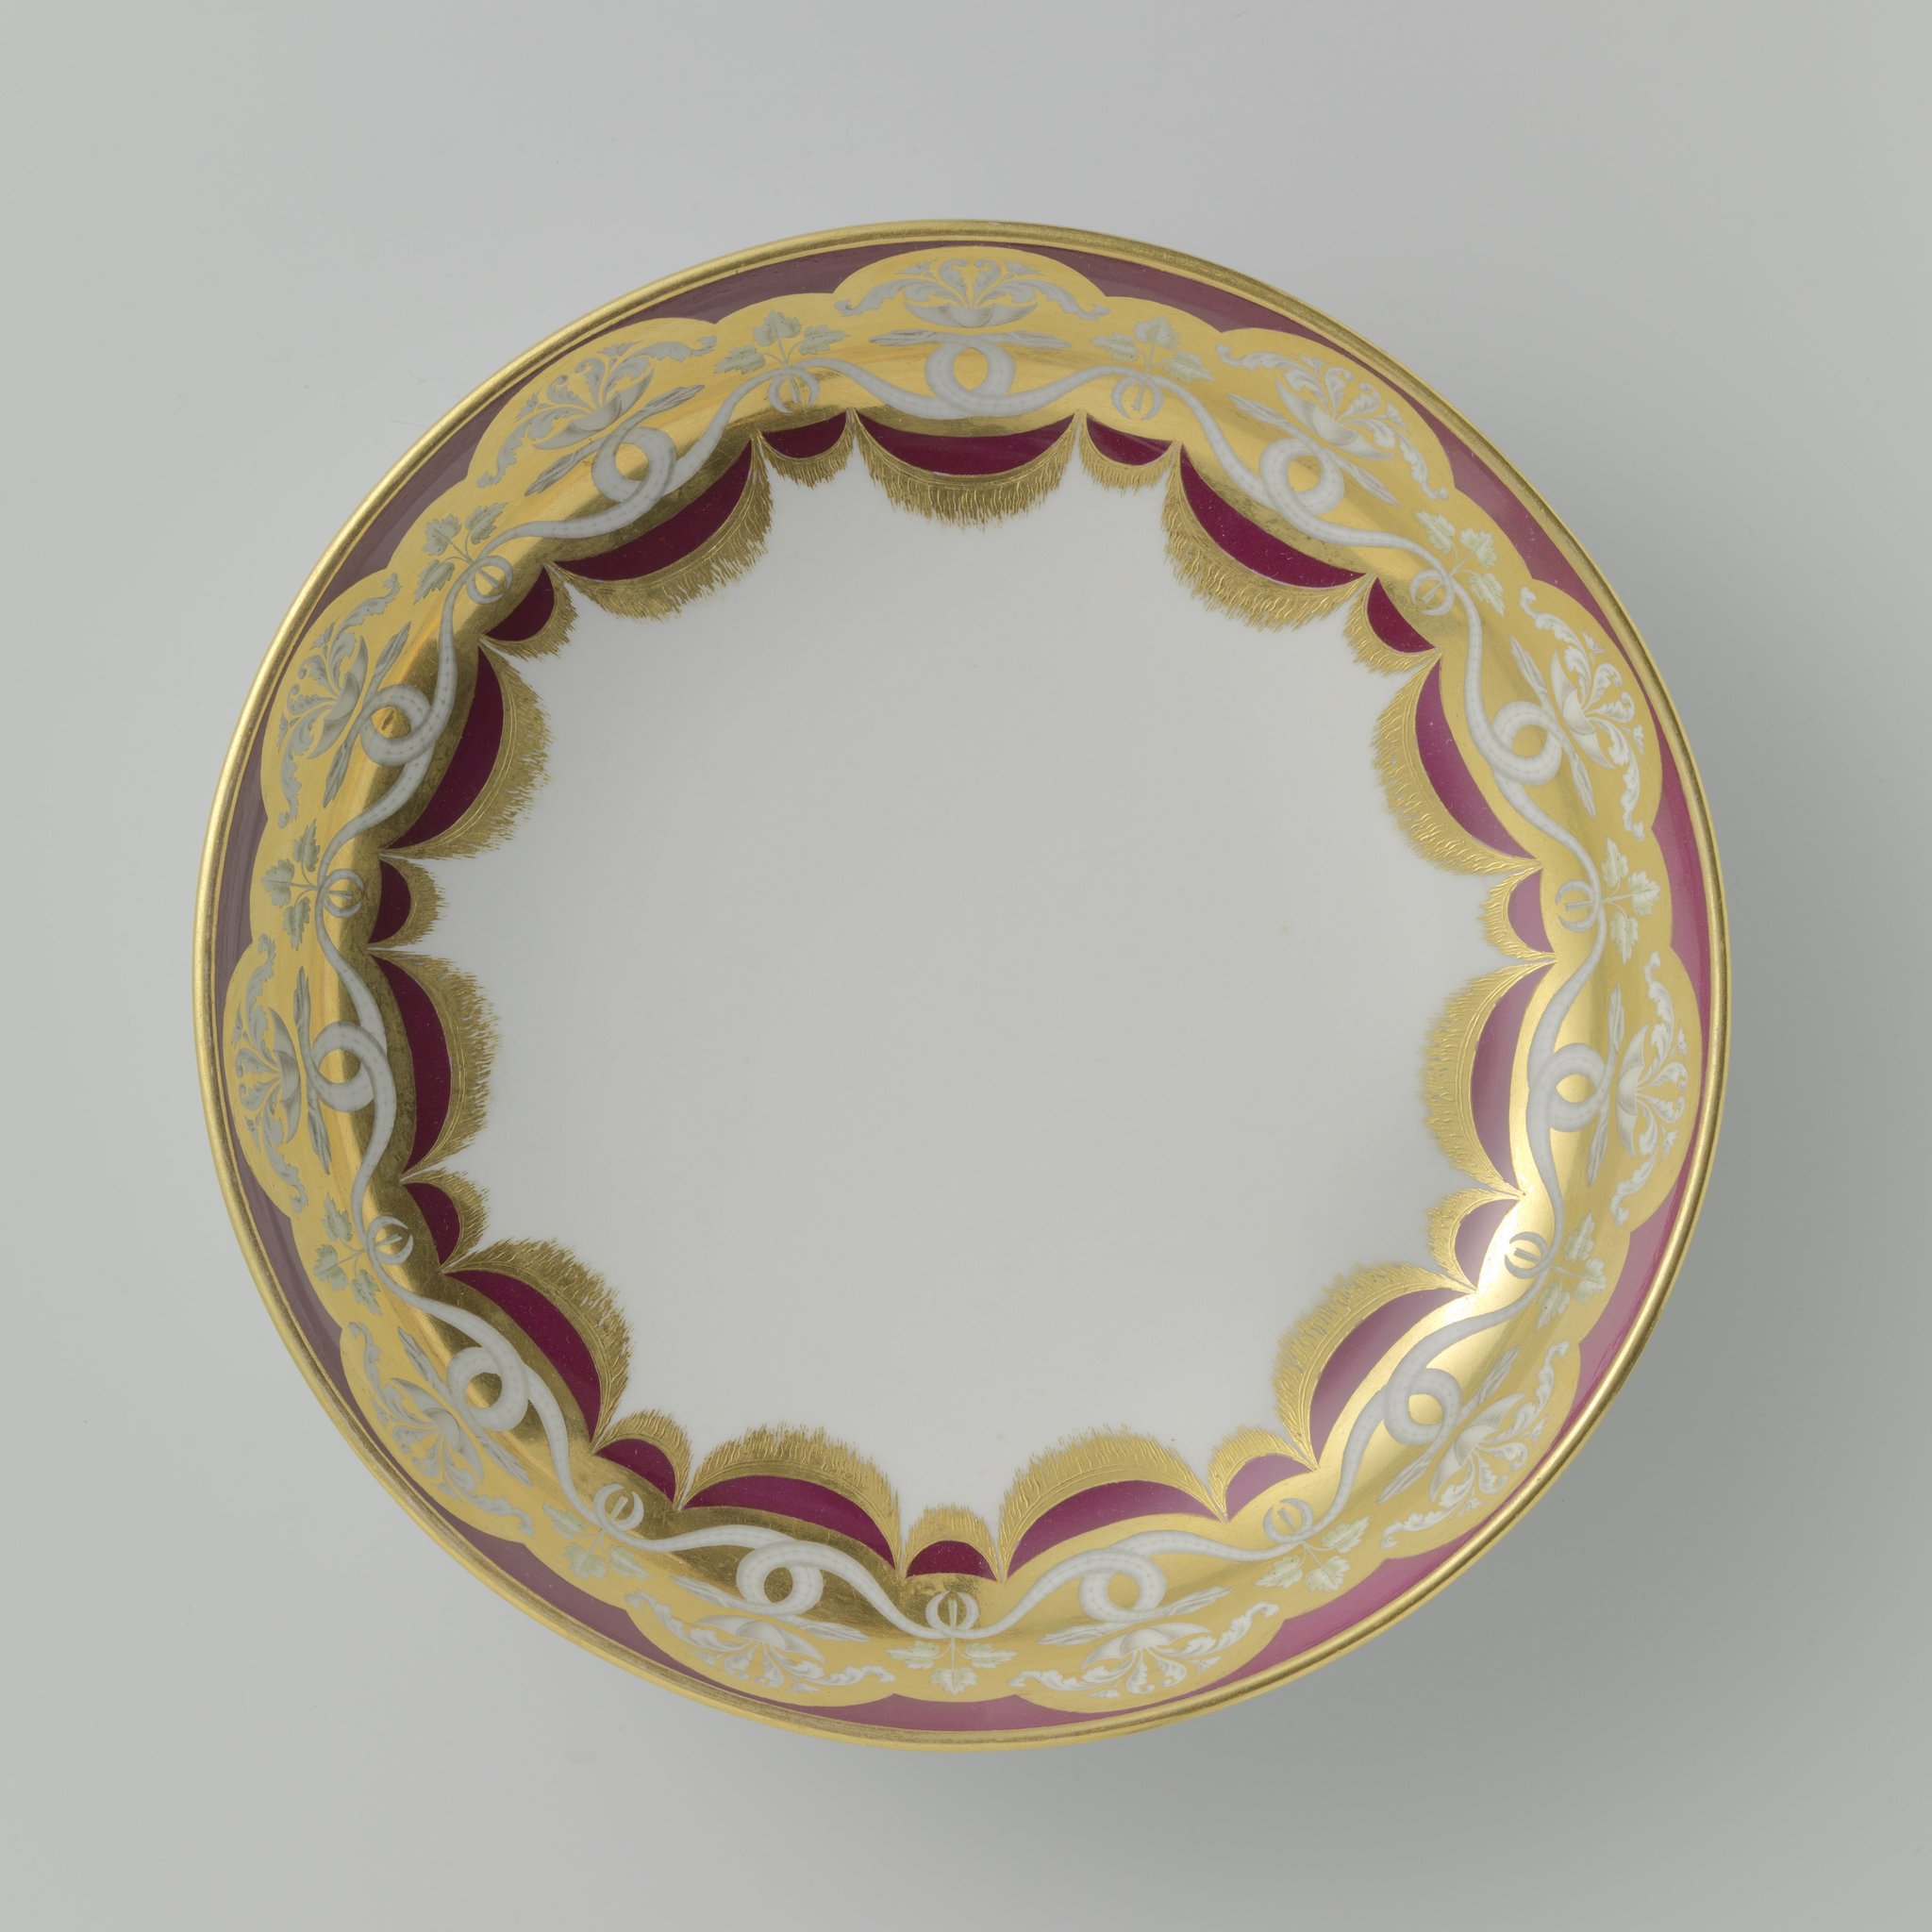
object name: dish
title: Dish with snakes and floral scrolls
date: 1804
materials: glaze, gold, paint, porcelain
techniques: firing, gilding, turning, vitrification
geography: vienna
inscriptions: mark: ‘schild/ 96/ 50/ 804’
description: Schaal. Porselein. Wenen, 1804.